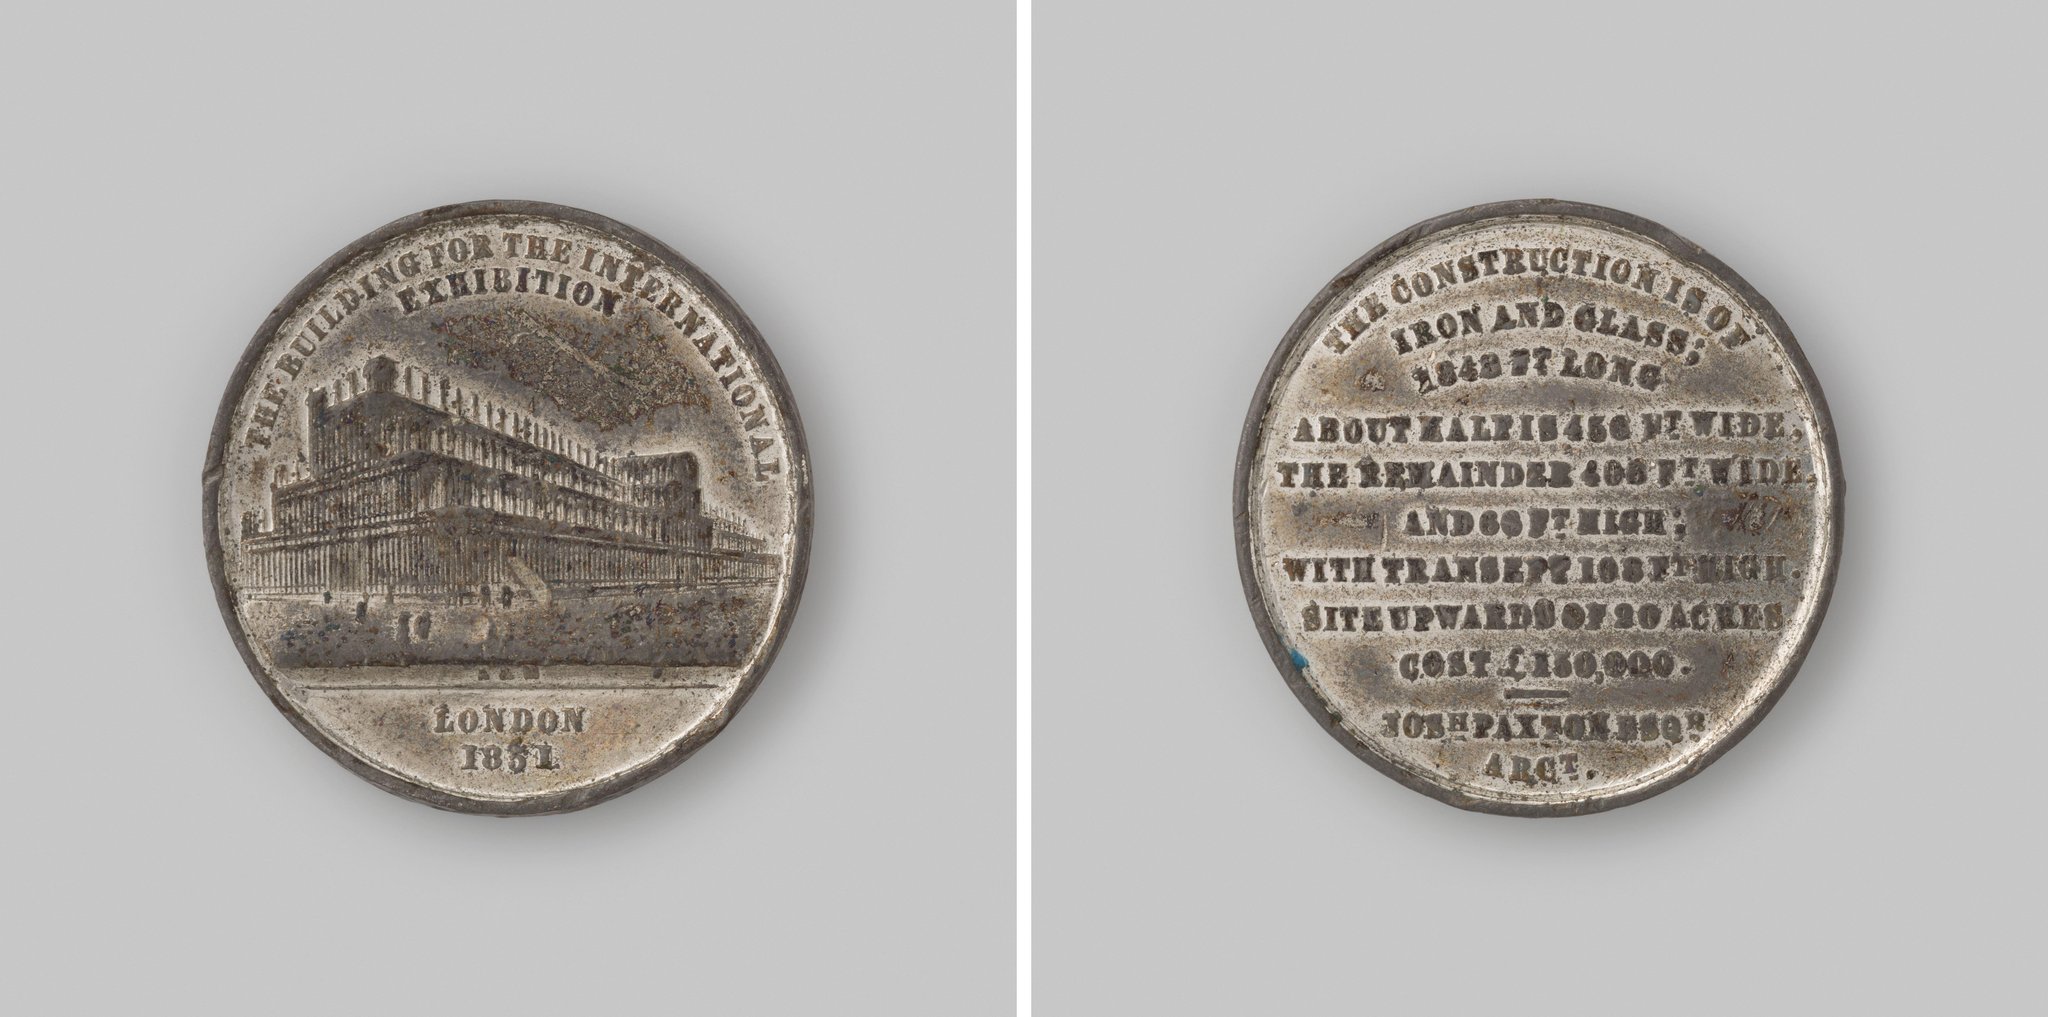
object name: history medal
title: Opening van het gebouw voor de Internationale Tentoonstelling te Londen 1851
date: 1851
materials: tin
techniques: striking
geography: birmingham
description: Tinnen penning, op de voorzijde twee regels tekst, het tentoonstellingsgebouw en twee regels tekst, op de keerzijde elf regels tekst.